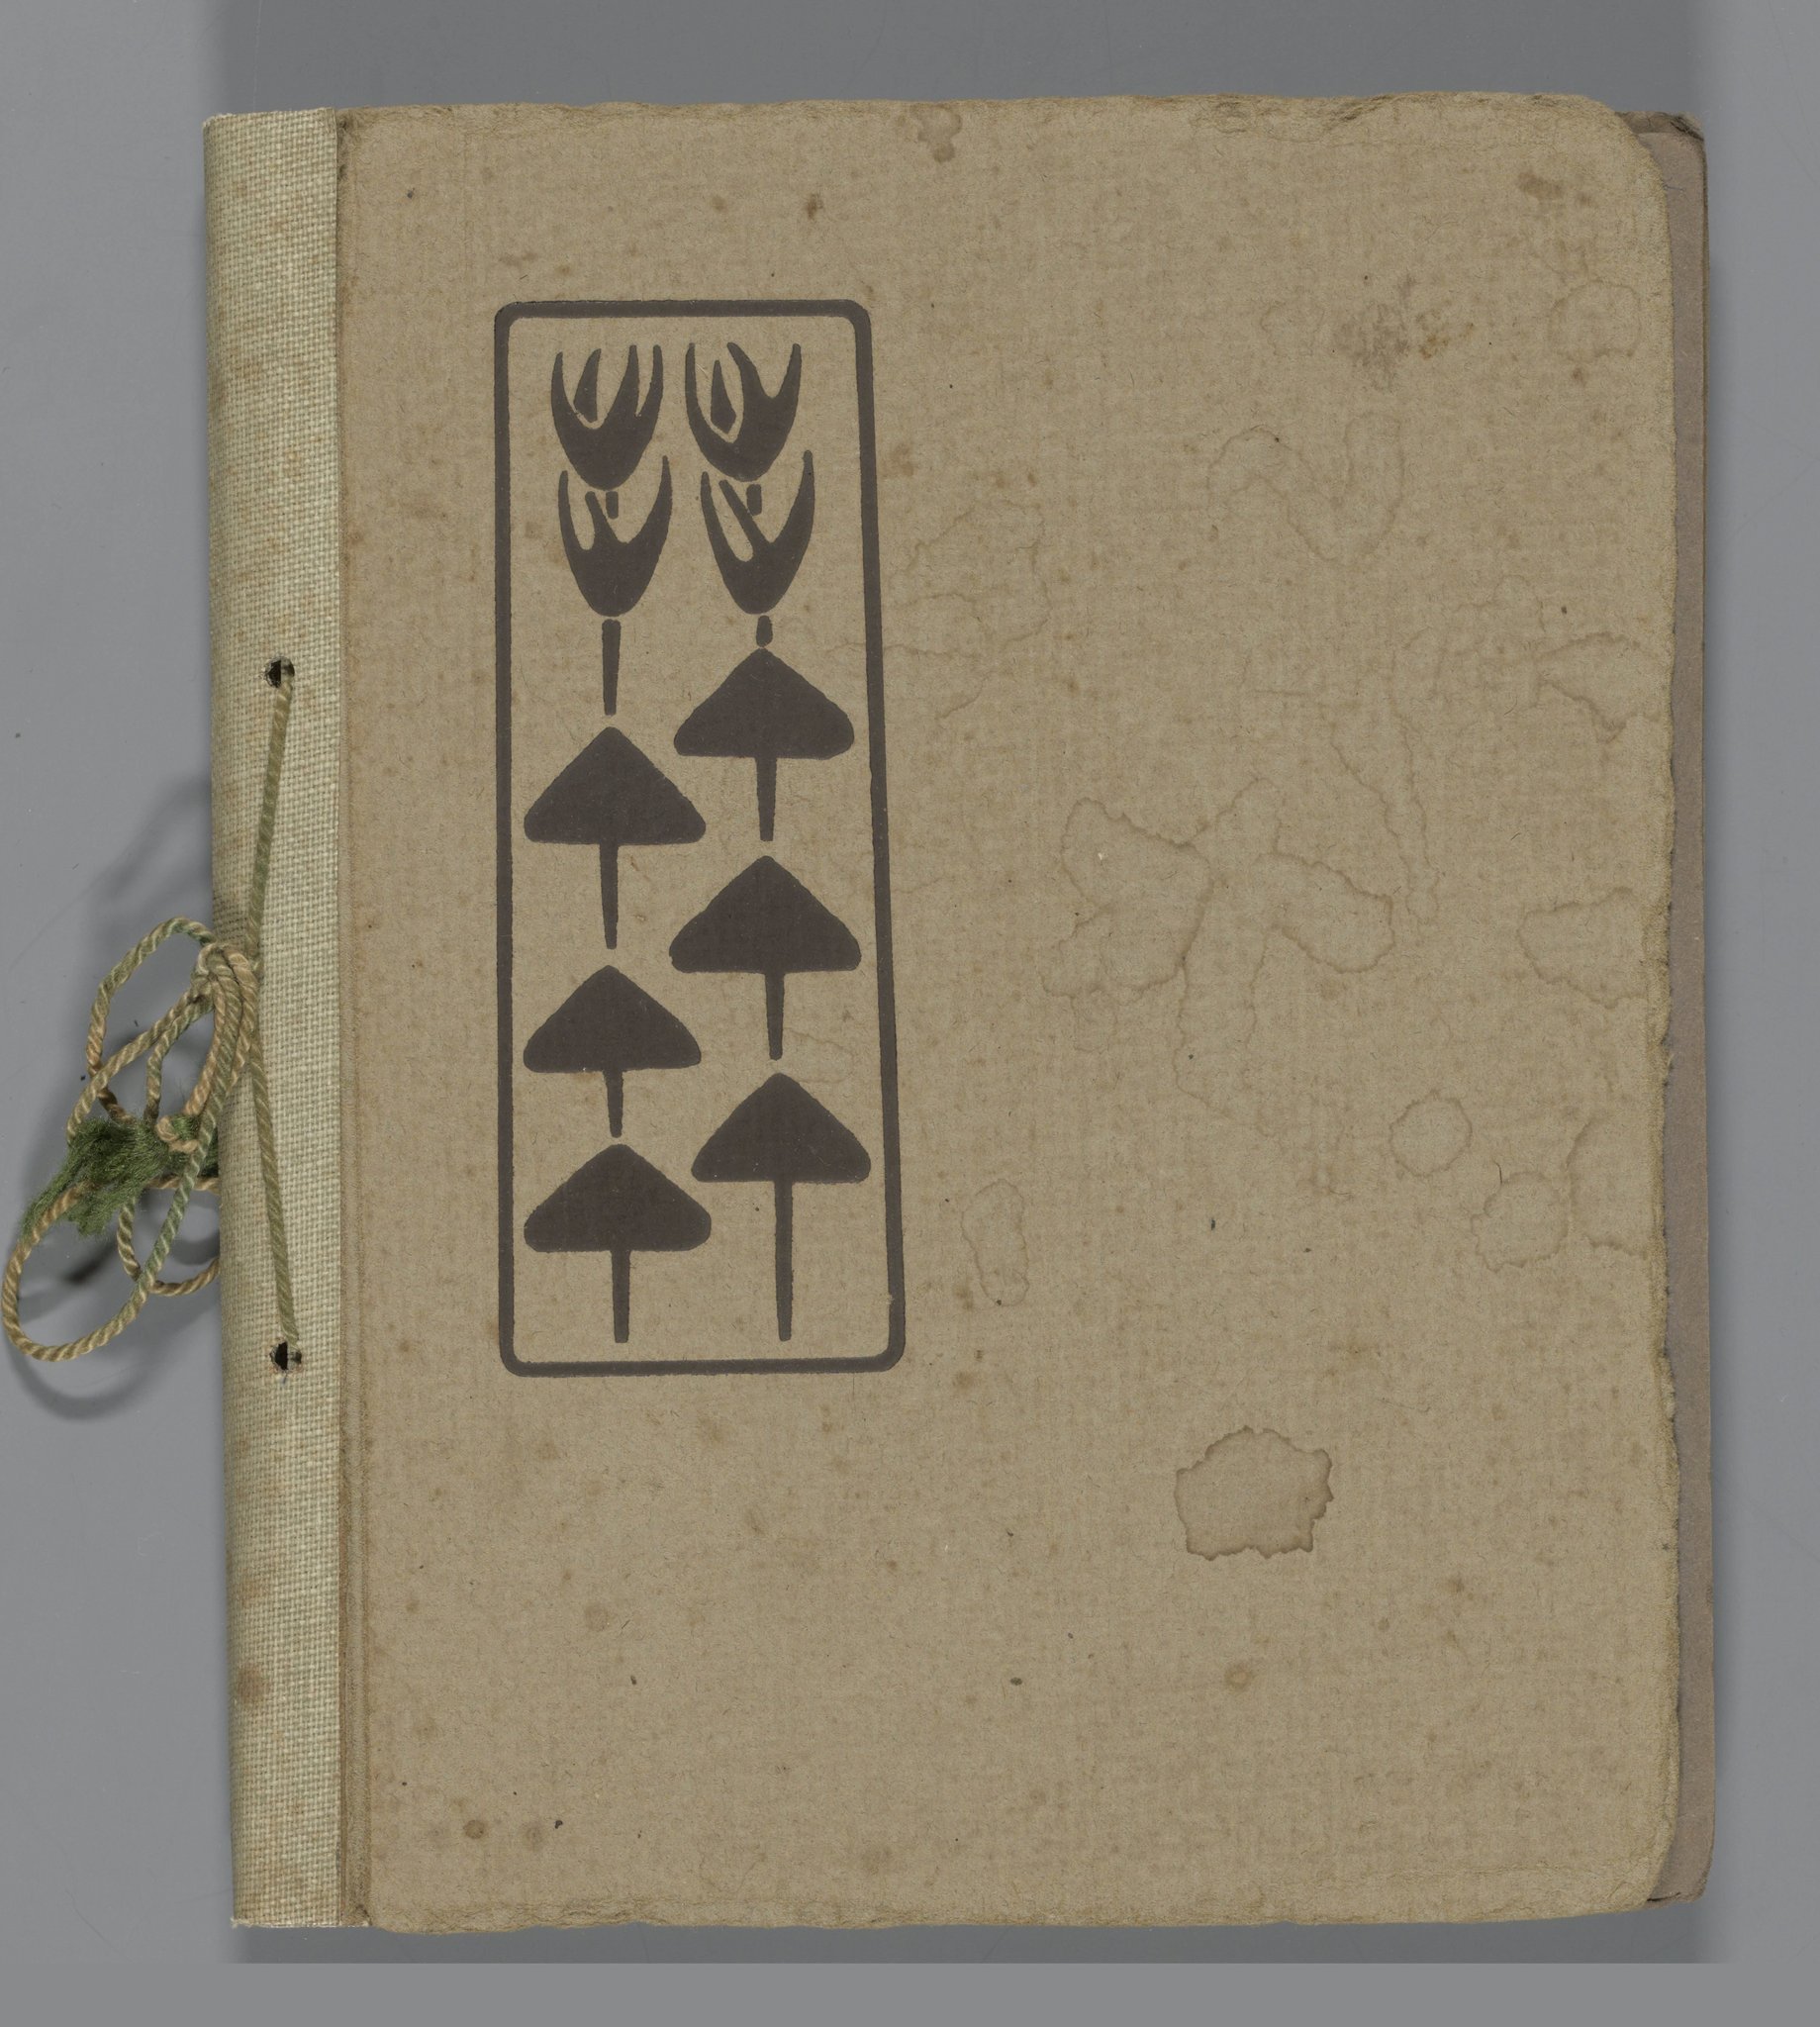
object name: photograph album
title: Fotoalbum over het leven van de familie Gonggrijp in Suriname rond 1912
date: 1912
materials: cardboard, linen, photographic support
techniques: photography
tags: suriname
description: Fotoalbum met een licht bruine voorkant van papier. Het album heeft 12 bladen van bruin karton met in totaal 65 foto's en wordt met een touwtje bij elkaar gehouden. Het album bevat verschillende onderwerpen zoals feestelijkheden op 19 april 1912 in Paramaribo, op het grote plein en langs de waterkant. In het album zitten foto's van Oom George Gonggrijp in Suriname die in Nederlands-Indië grote bekendheid zou verwerven als "de opheffer", een pseudoniem dat hij gebruikte voor zijn columns in het Bataviaasch Handelsblad. Ook foto's van de tennisclub in Paramaribo, schepen, familie en vrienden, plantage Clevia en Morgenstond en van de stad Paramaribo. Op een van de foto's staat Andries Boom met fotocamera in de hand.